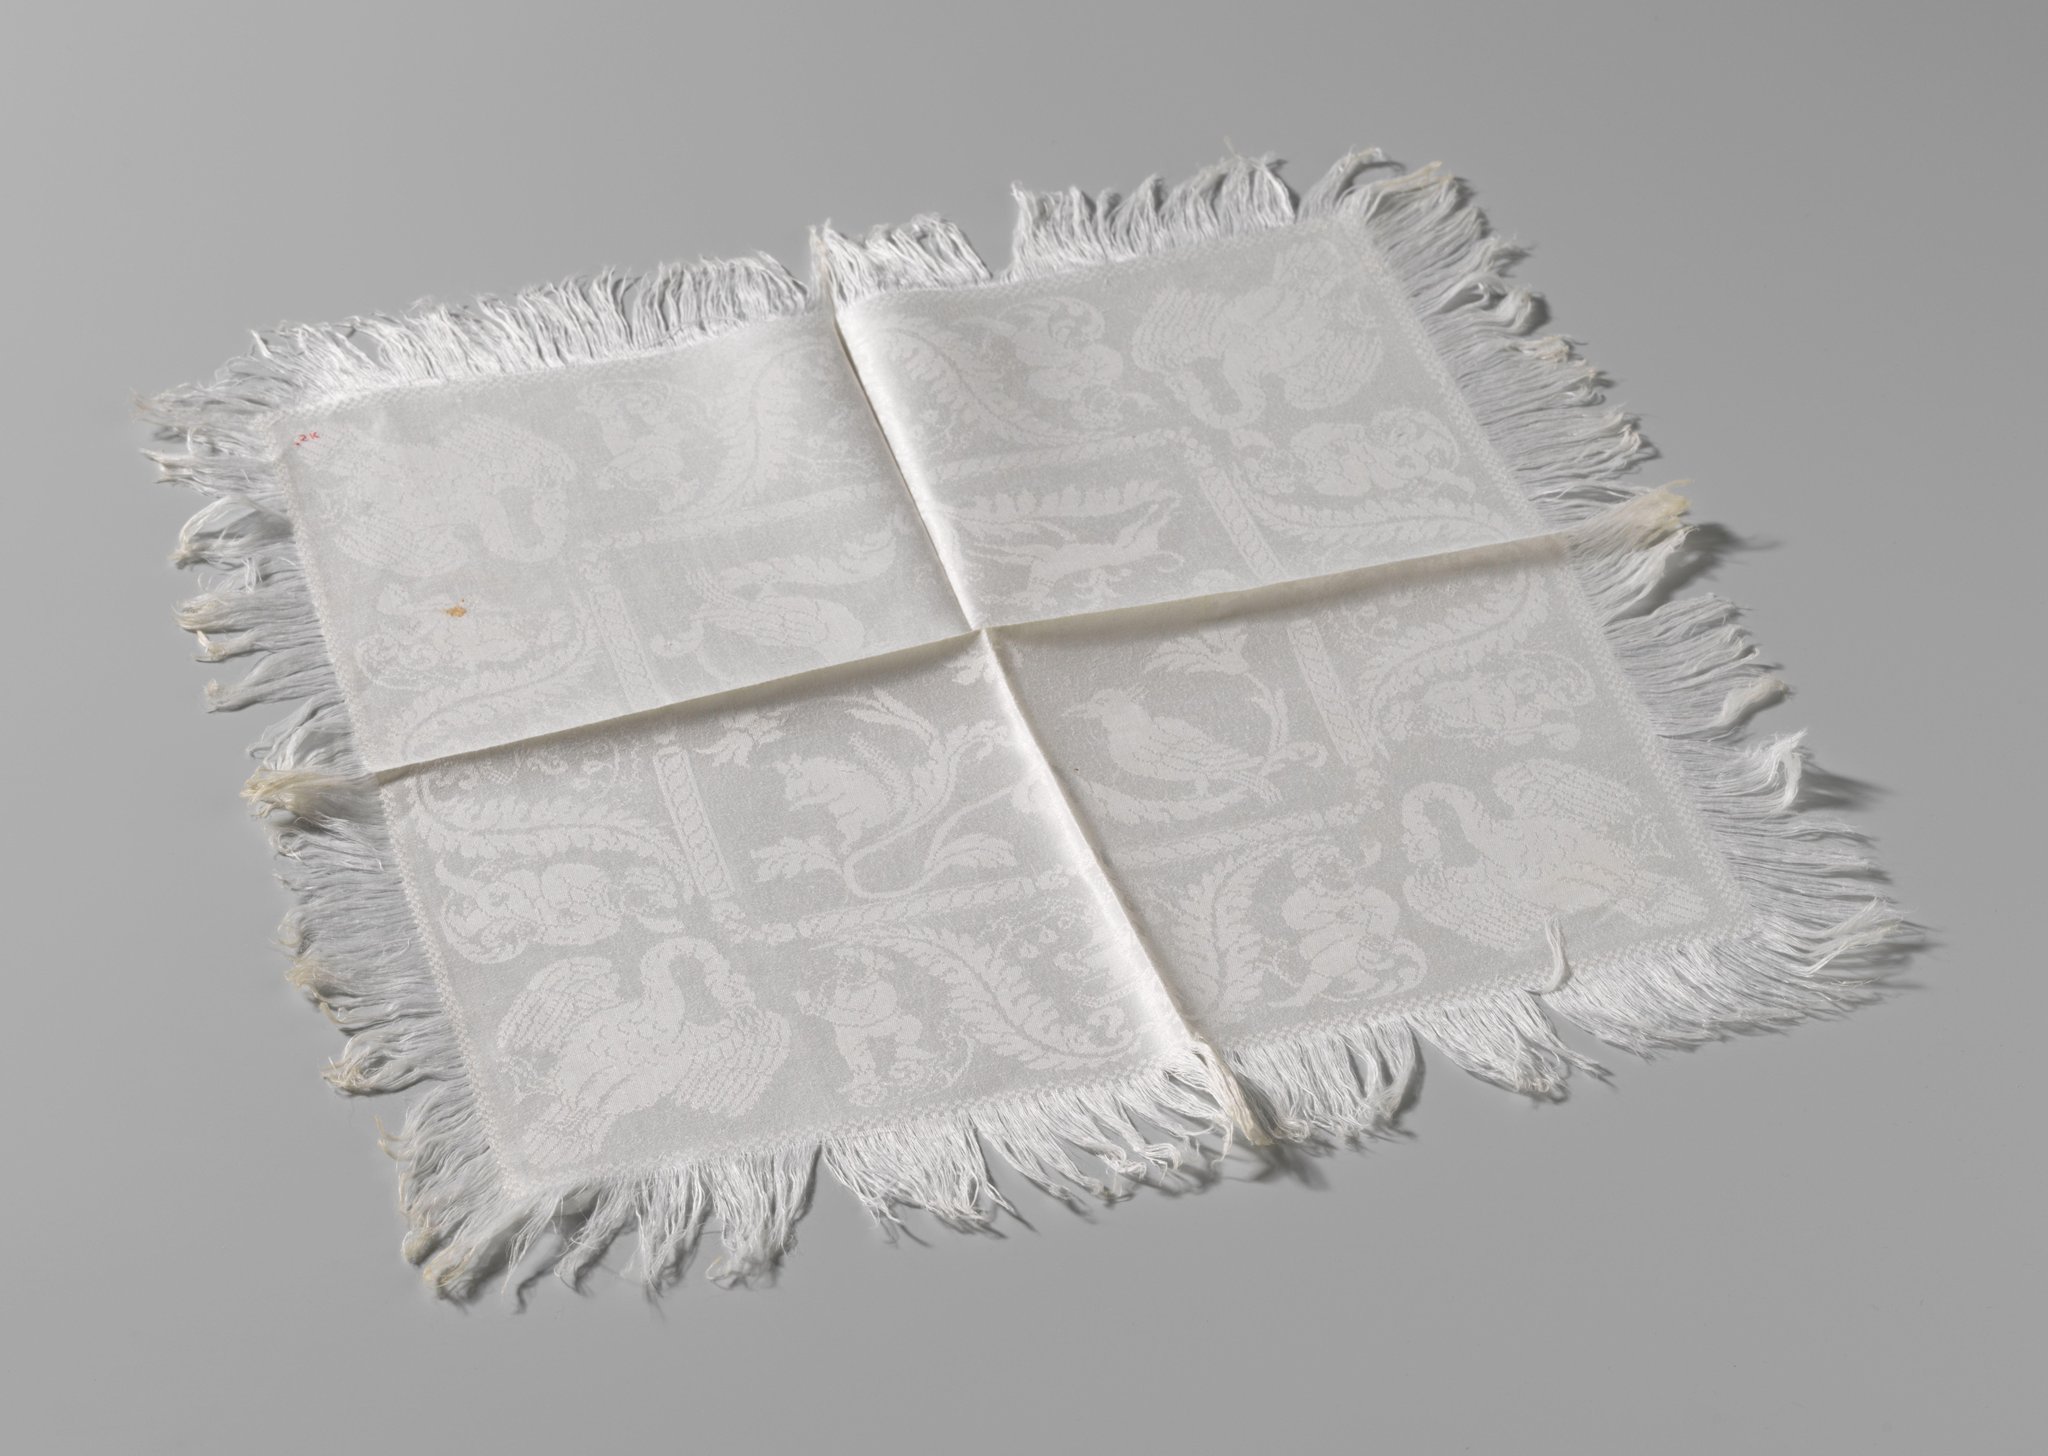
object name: napkin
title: Pijprokende Turken.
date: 1850-1899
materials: linen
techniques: damask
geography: veghel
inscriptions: mark: ‘ZK’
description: Vingerdoek van wit linnendamast, met dessin van pijprokende Turken.